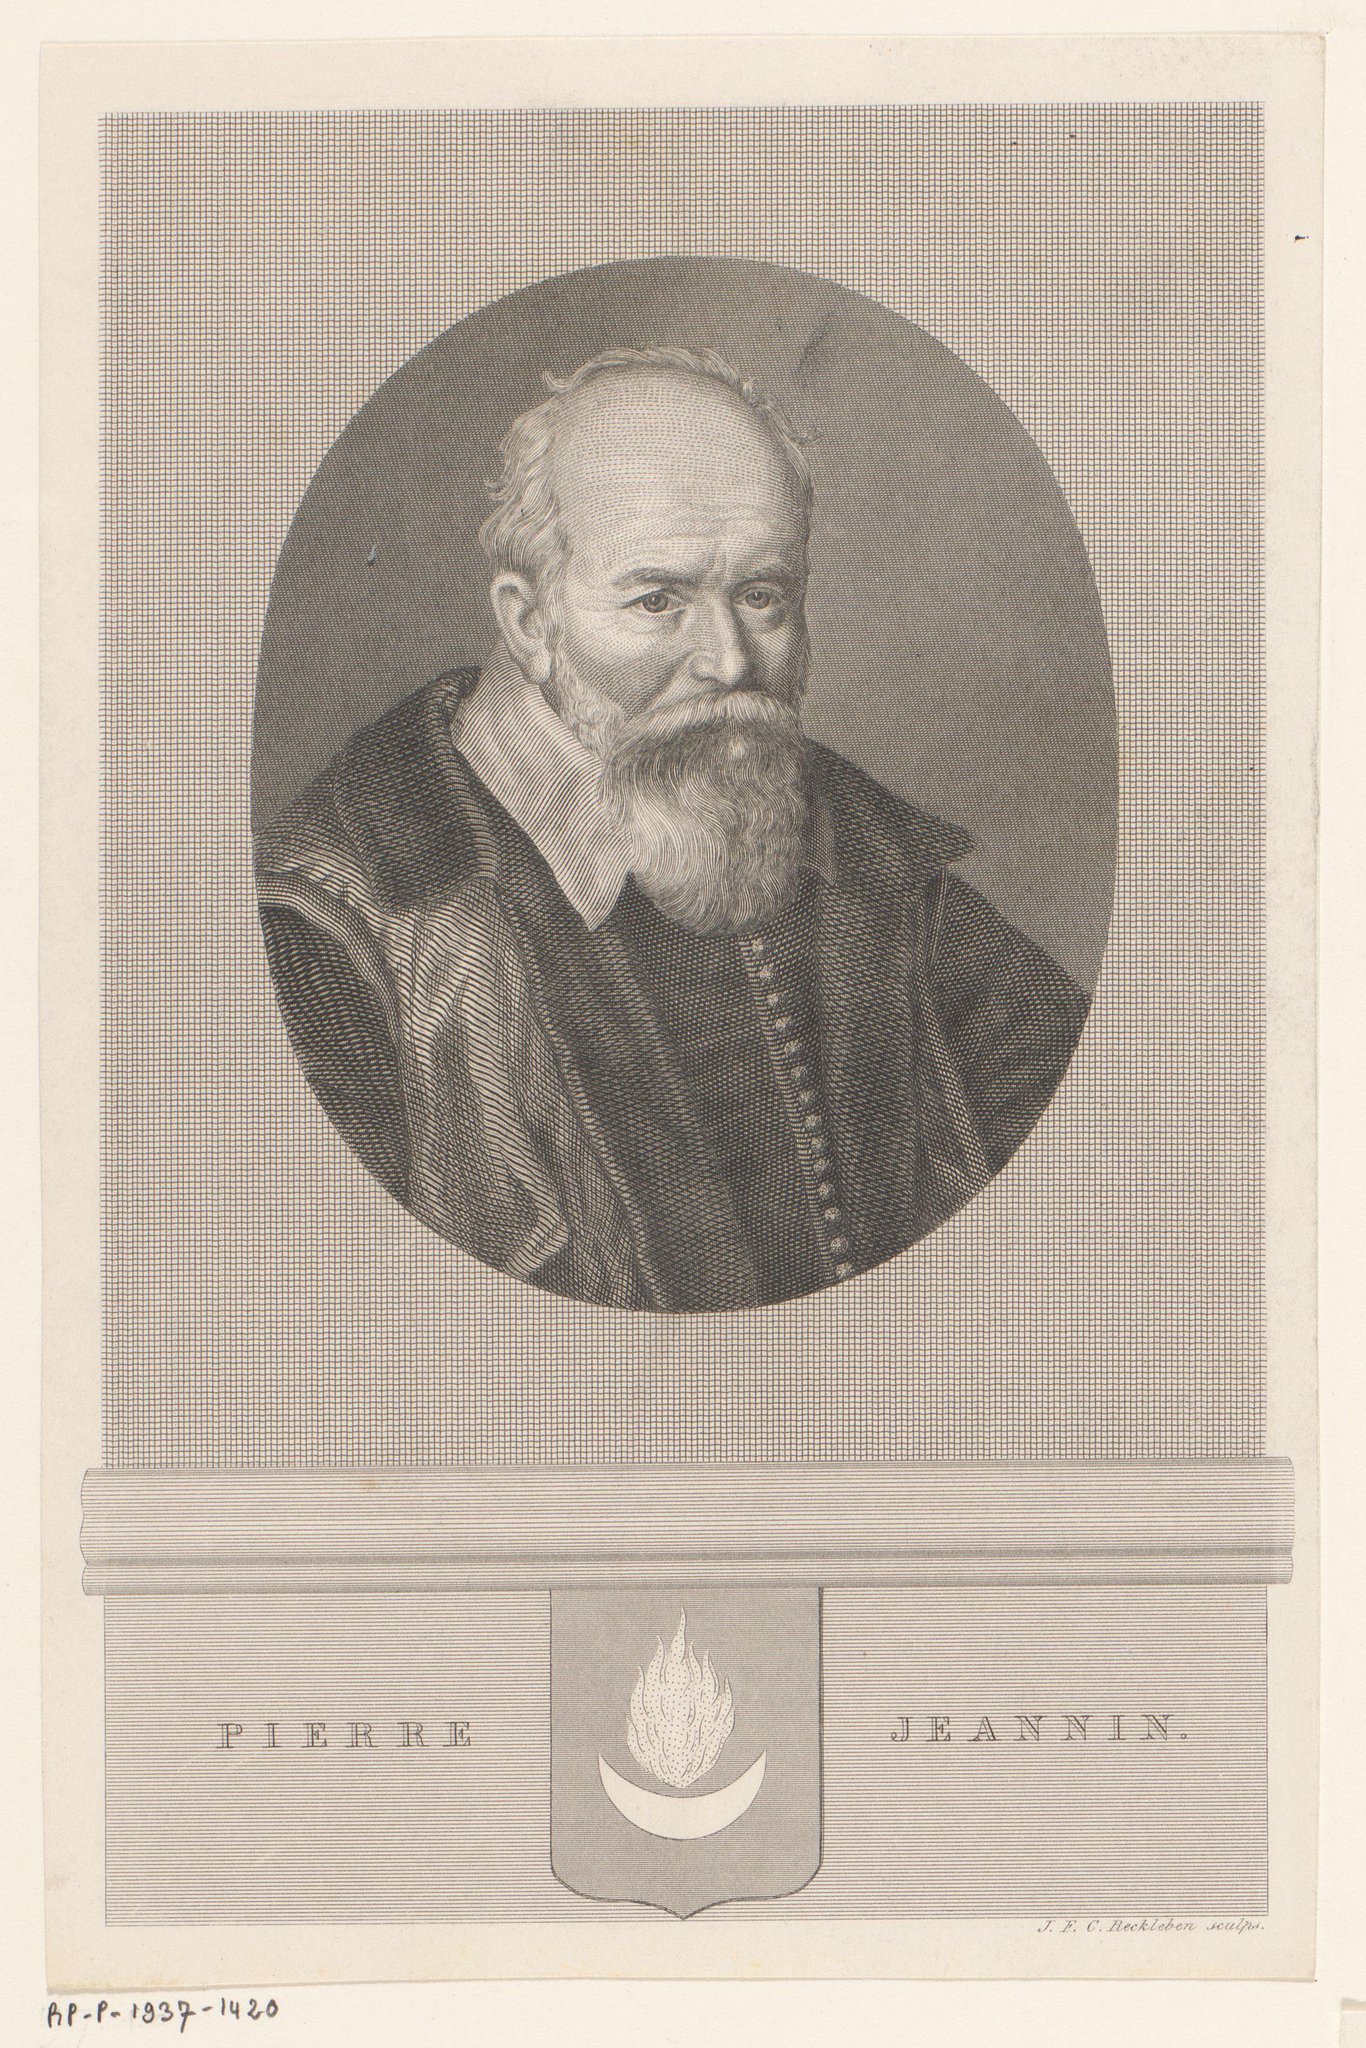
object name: print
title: Portret van Pierre Jeannin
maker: jan frederik christiaan reckleben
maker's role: print maker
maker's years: 1819-1879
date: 1855-1857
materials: paper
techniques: engraving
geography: amsterdam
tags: paris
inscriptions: collector's mark: Lugt 2228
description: Illustratie in: Arend, Johannes Pieter. Algemeene geschiedenis des vaderlands van de vroegste tijden tot op heden. 5 delen, Amsterdam: Schleijer, J.F. 1840-1884, dl. 3.2, p. 268.